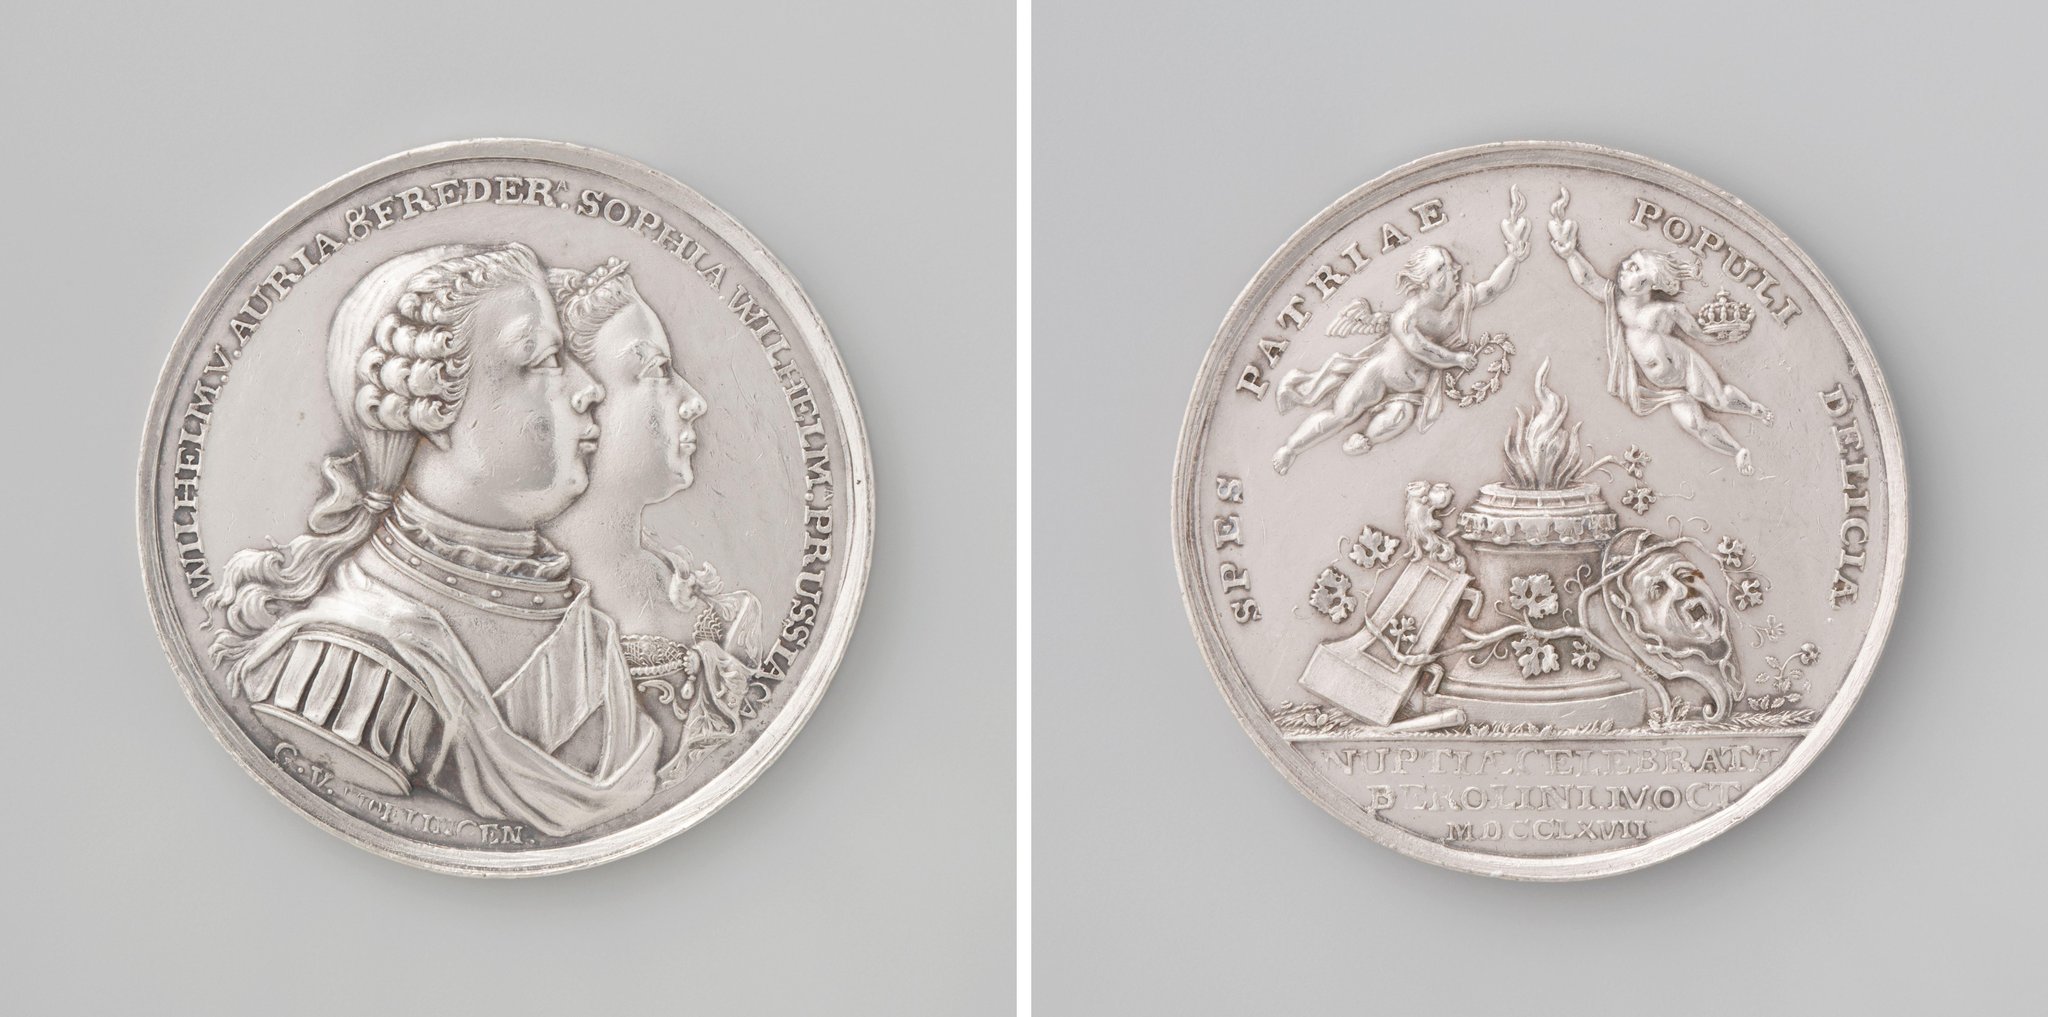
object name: history medal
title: Huwelijk van Willem V met Wilhelmina Frederica Sophia van Pruisen te Berlijn, penning aangeboden aan de schutters van Amsterdam tijdens een vergadering in de Doelen en aan de brandmeesters van 's-Grav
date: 1767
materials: silver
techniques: striking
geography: the hague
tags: the hague, william v (prince of orange), painter, wilhelmina of prussia (princess of orange), berlin